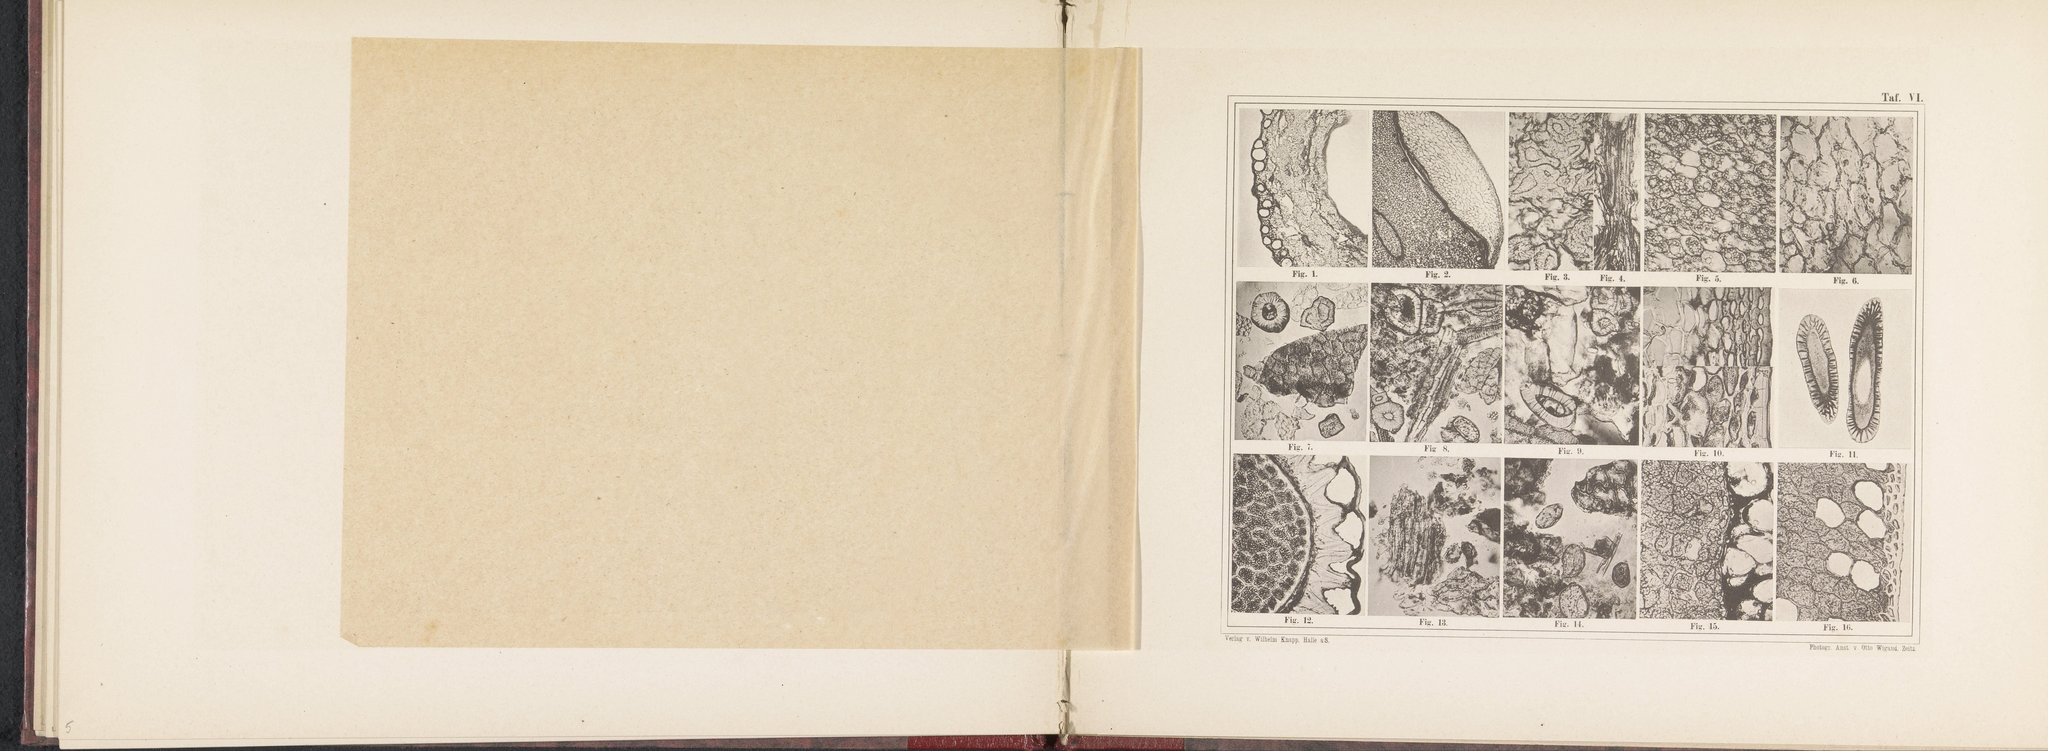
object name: page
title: Blad met zestien microscopische opnamen van de celstructuur van piment, Spaanse peper, foelie en de muskaatnoot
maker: franz friedrich bernard elsner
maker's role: medicus, psychiater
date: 1874-1884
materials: paper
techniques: photograph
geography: halle an der saale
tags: pepper, microscope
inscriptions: number: ‘Taf. VI.’